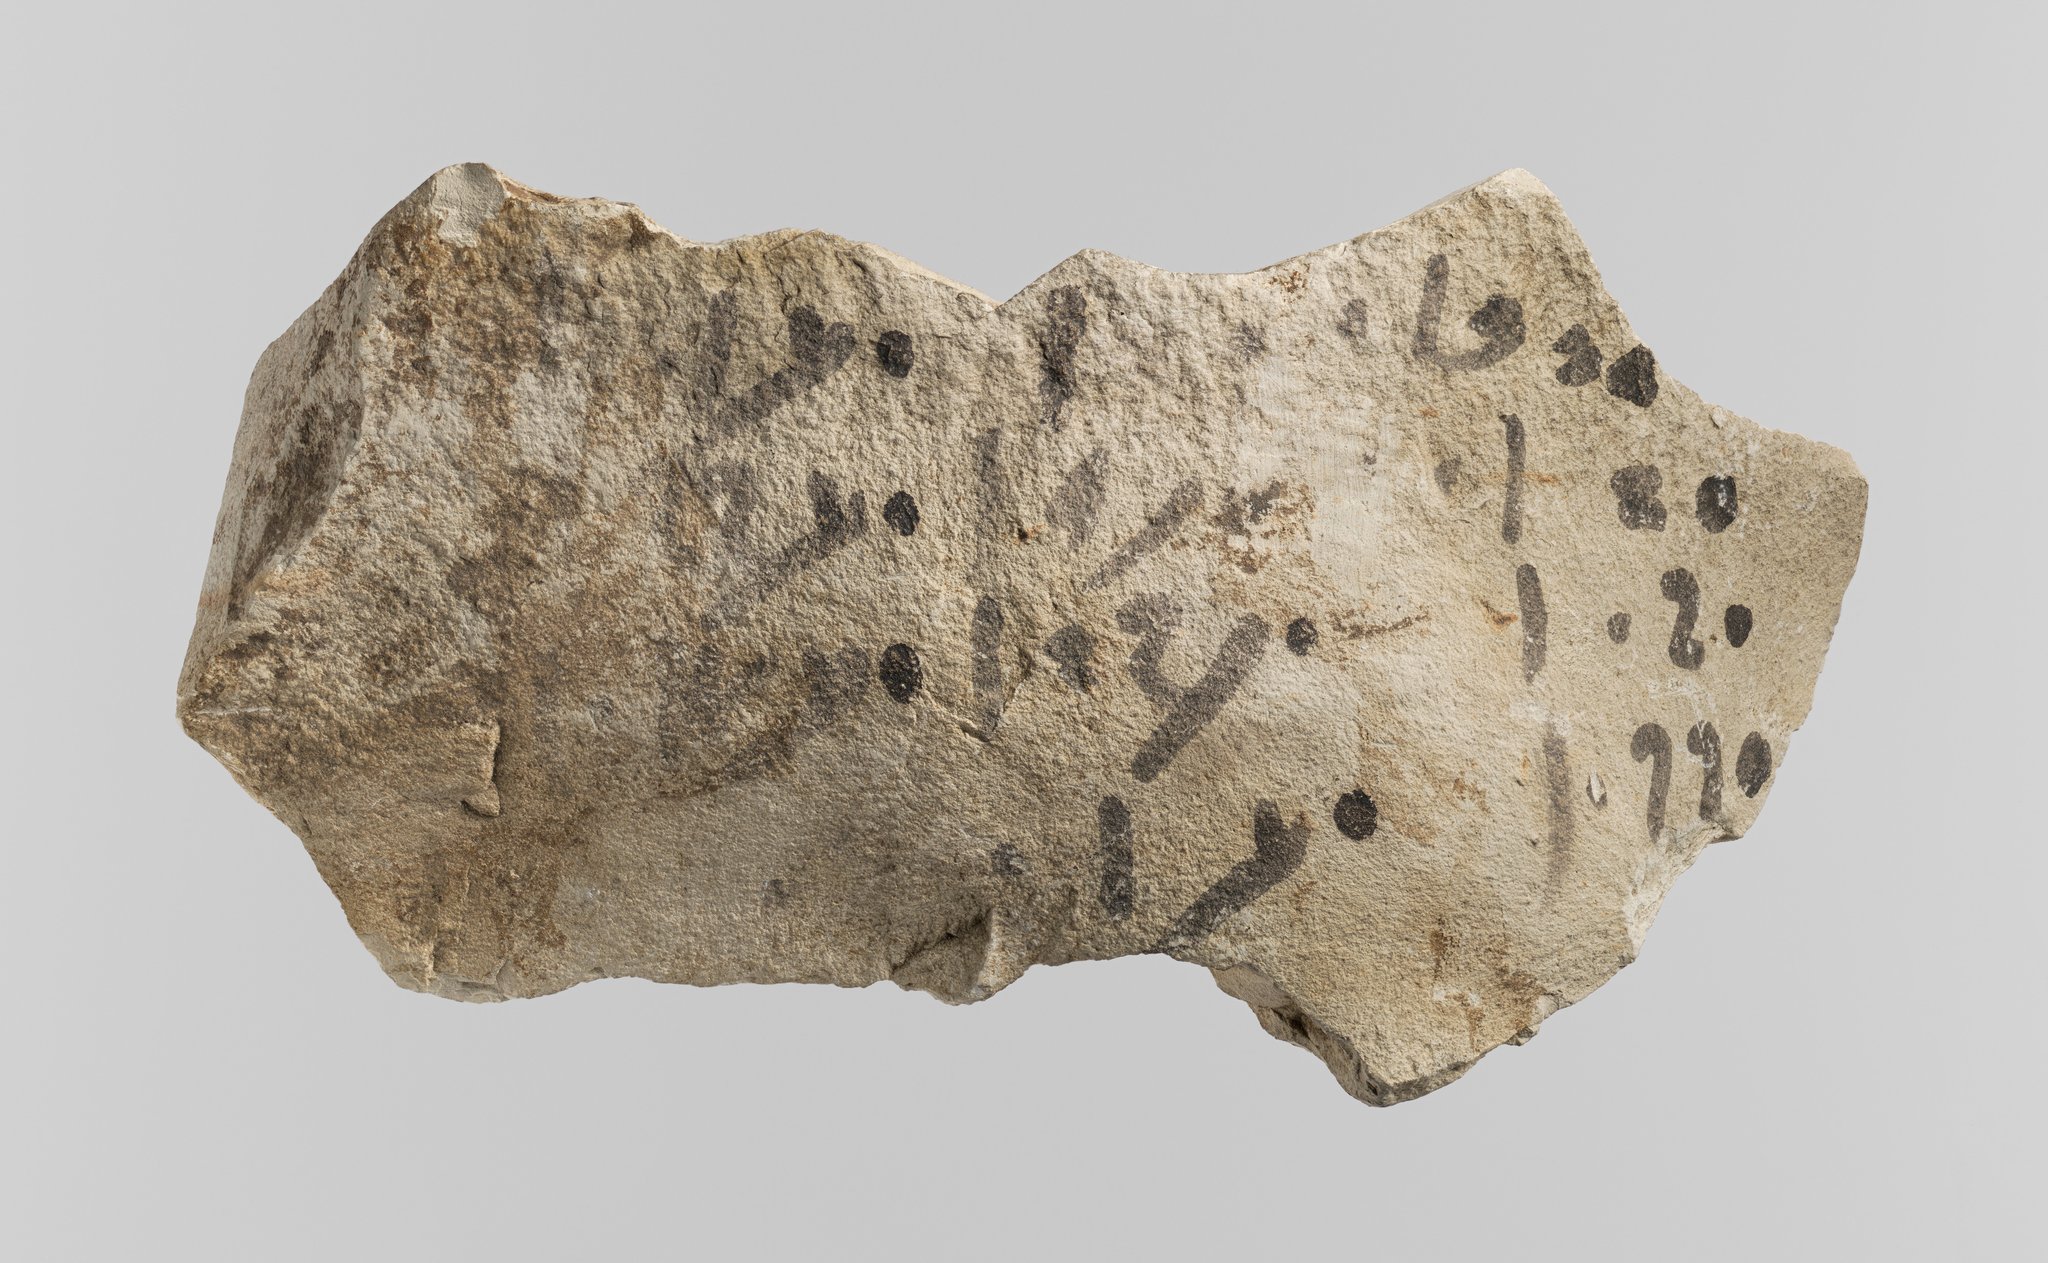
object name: ostracon, hieratic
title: Hieratic ostracon with three columns of accounts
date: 525-404 BCE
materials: ink, limestone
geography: egypt